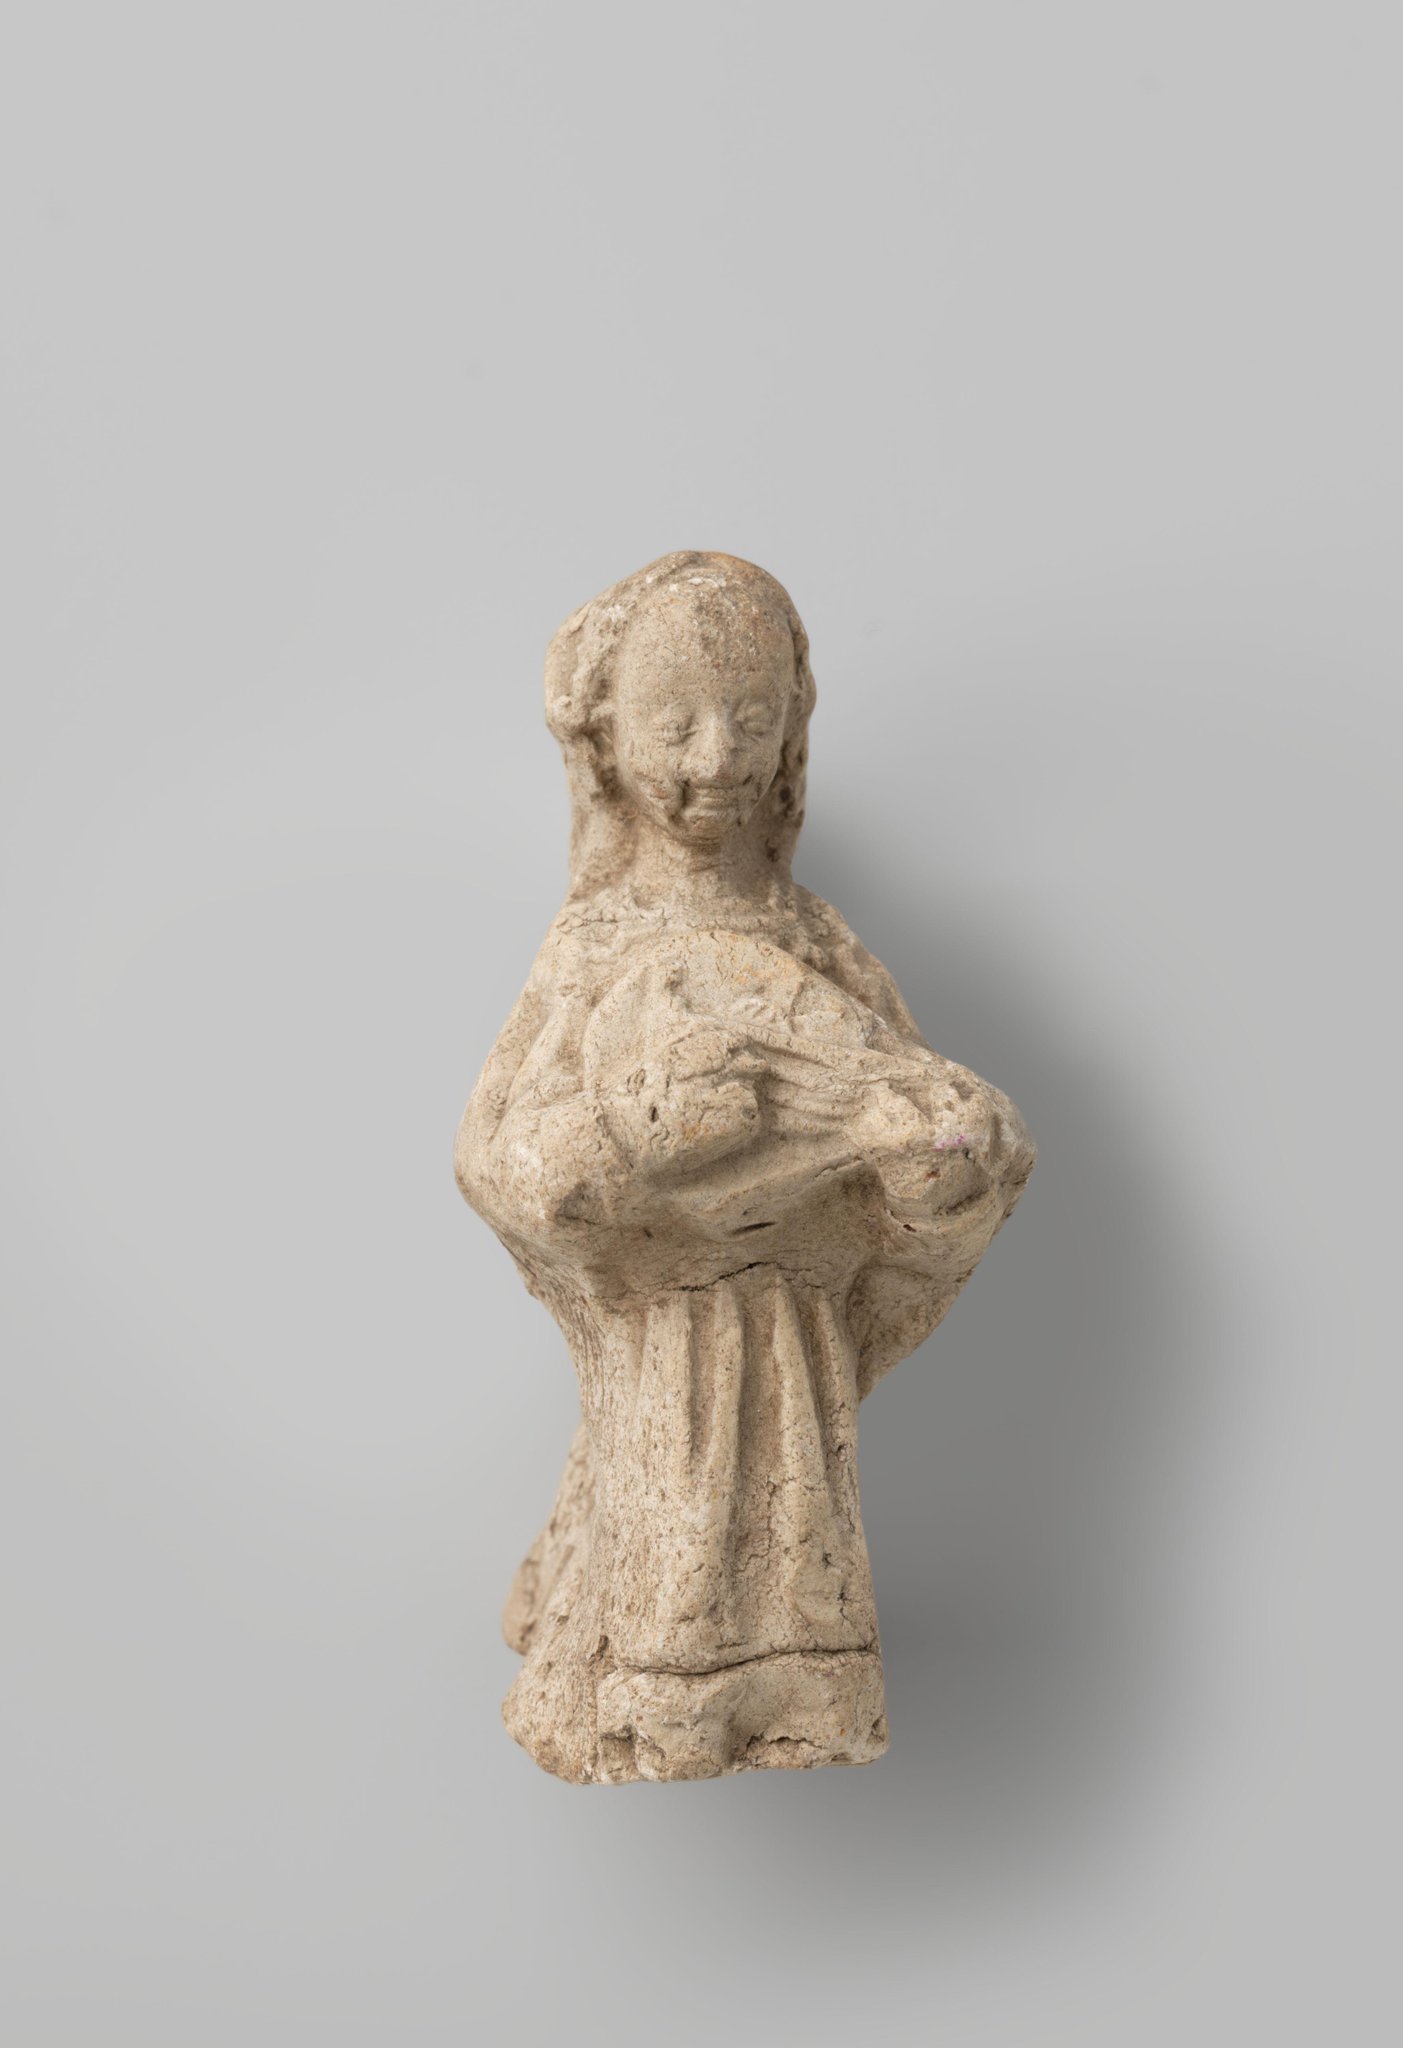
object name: sculpture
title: Angel Playing a Lute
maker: Anonymous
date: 1450-1500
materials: clay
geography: utrecht